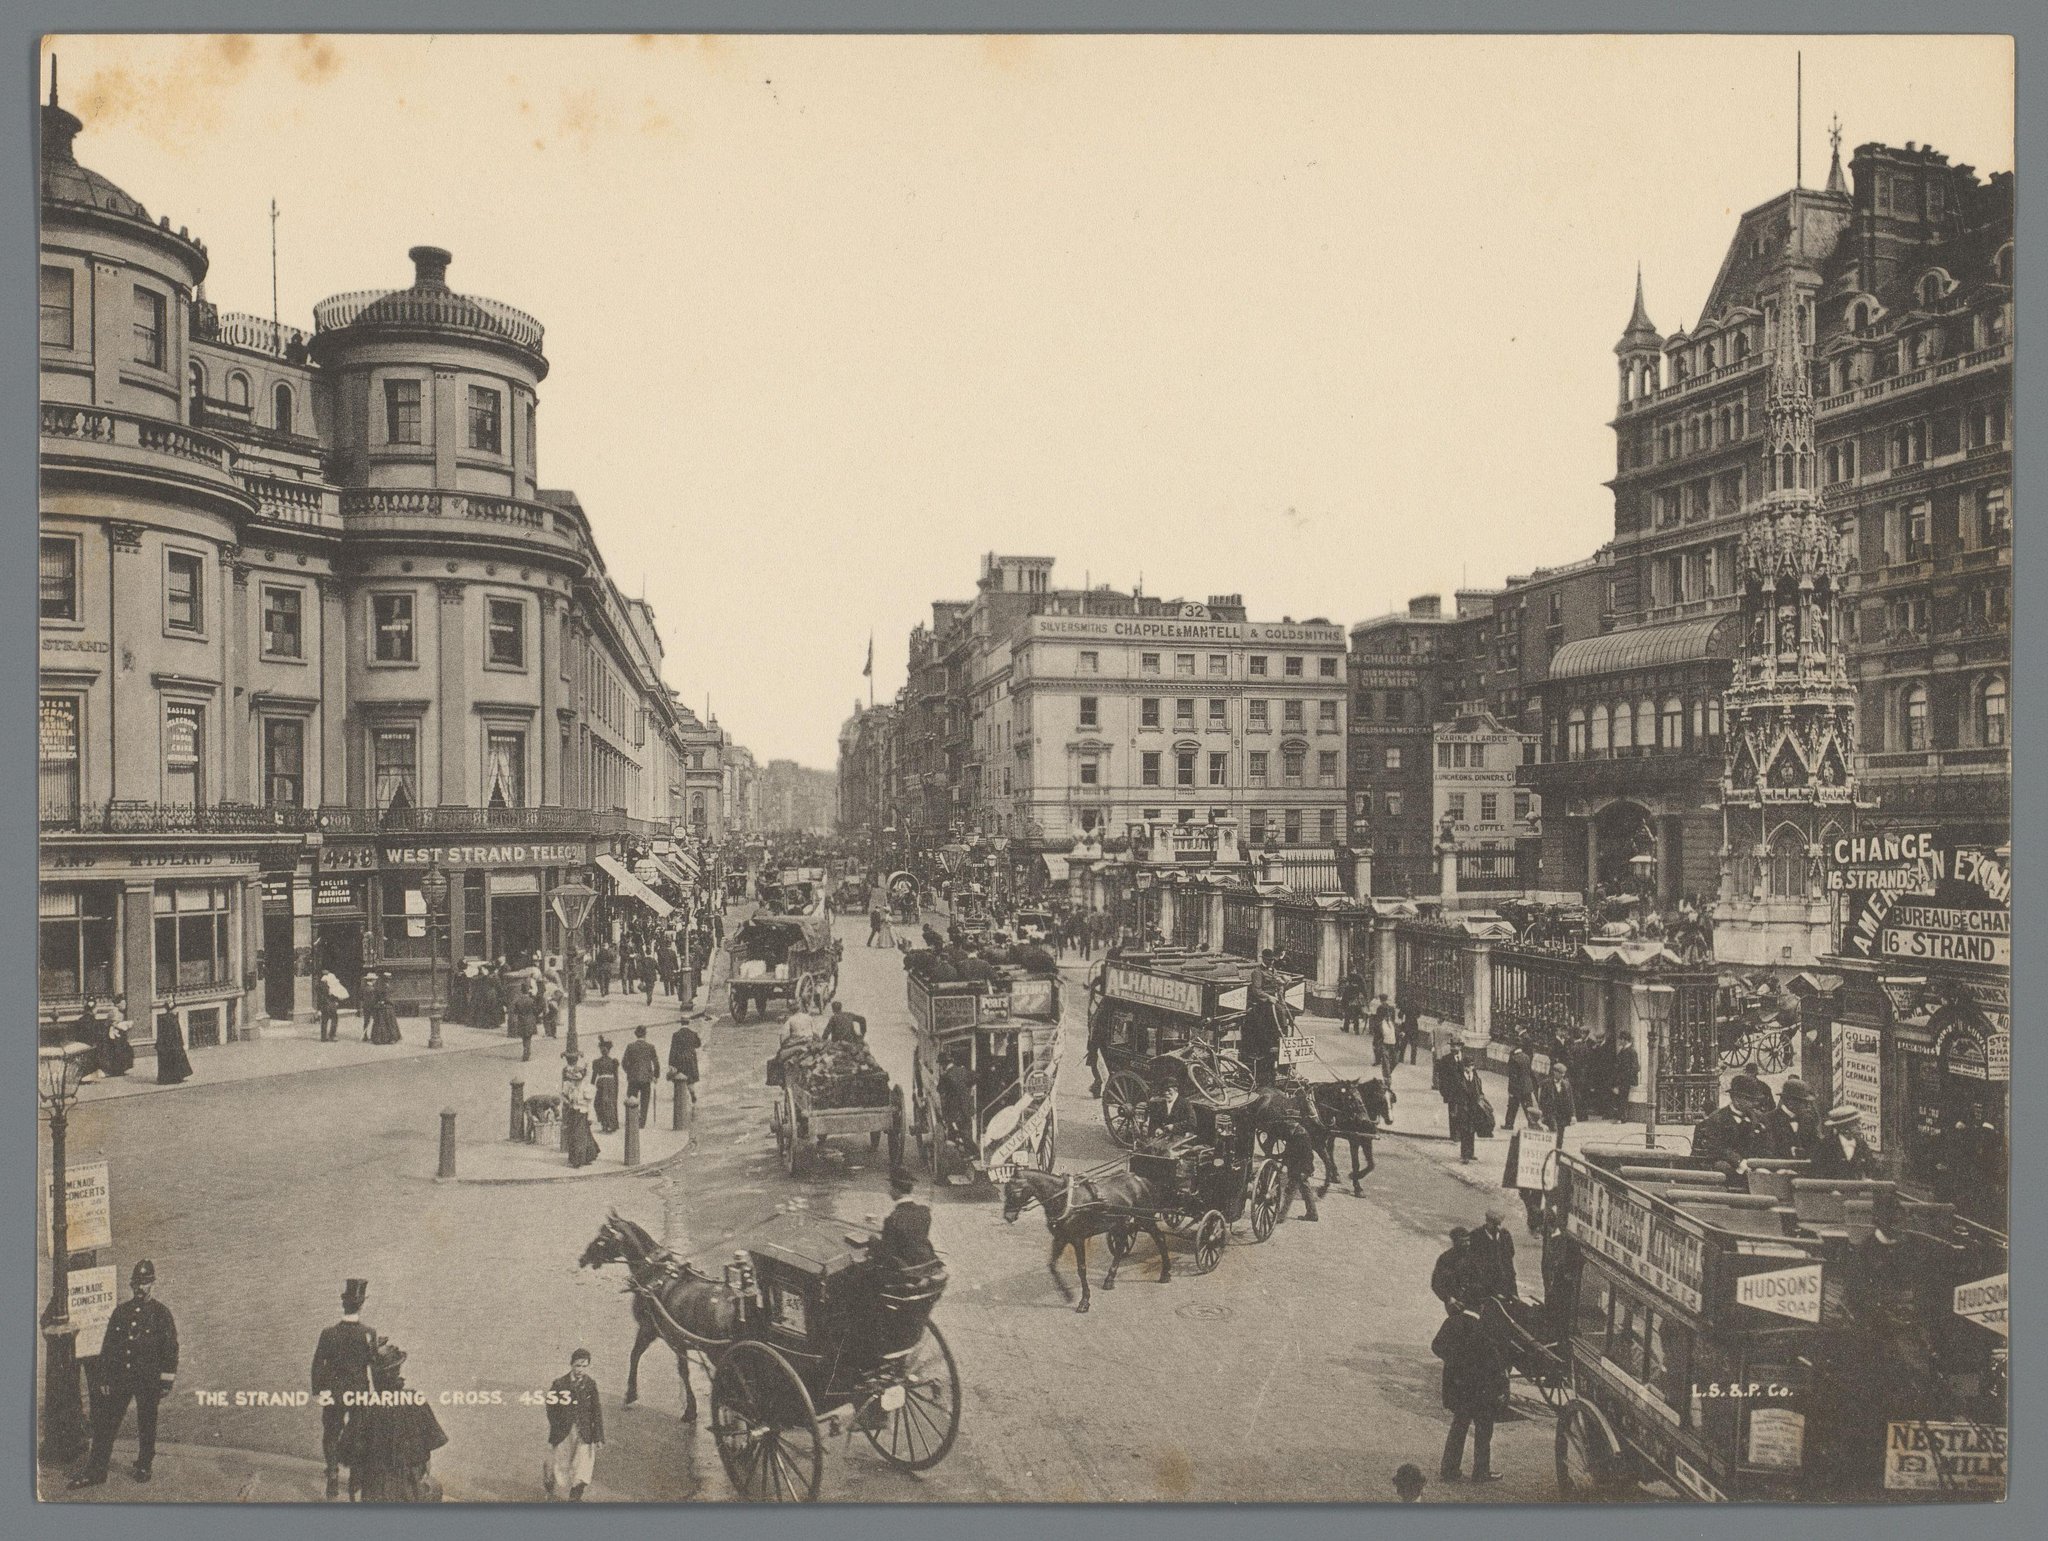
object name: photomechanical print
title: The Strand & Charing Cross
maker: Anonymous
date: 1870-1922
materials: paper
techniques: photograph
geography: london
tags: square, place, circus, etc., urban housing, street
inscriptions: number: ‘4553.’